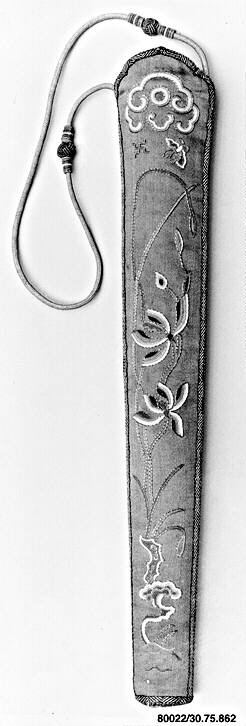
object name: fan holder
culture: chinese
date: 1701-1900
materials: metal thread, silk